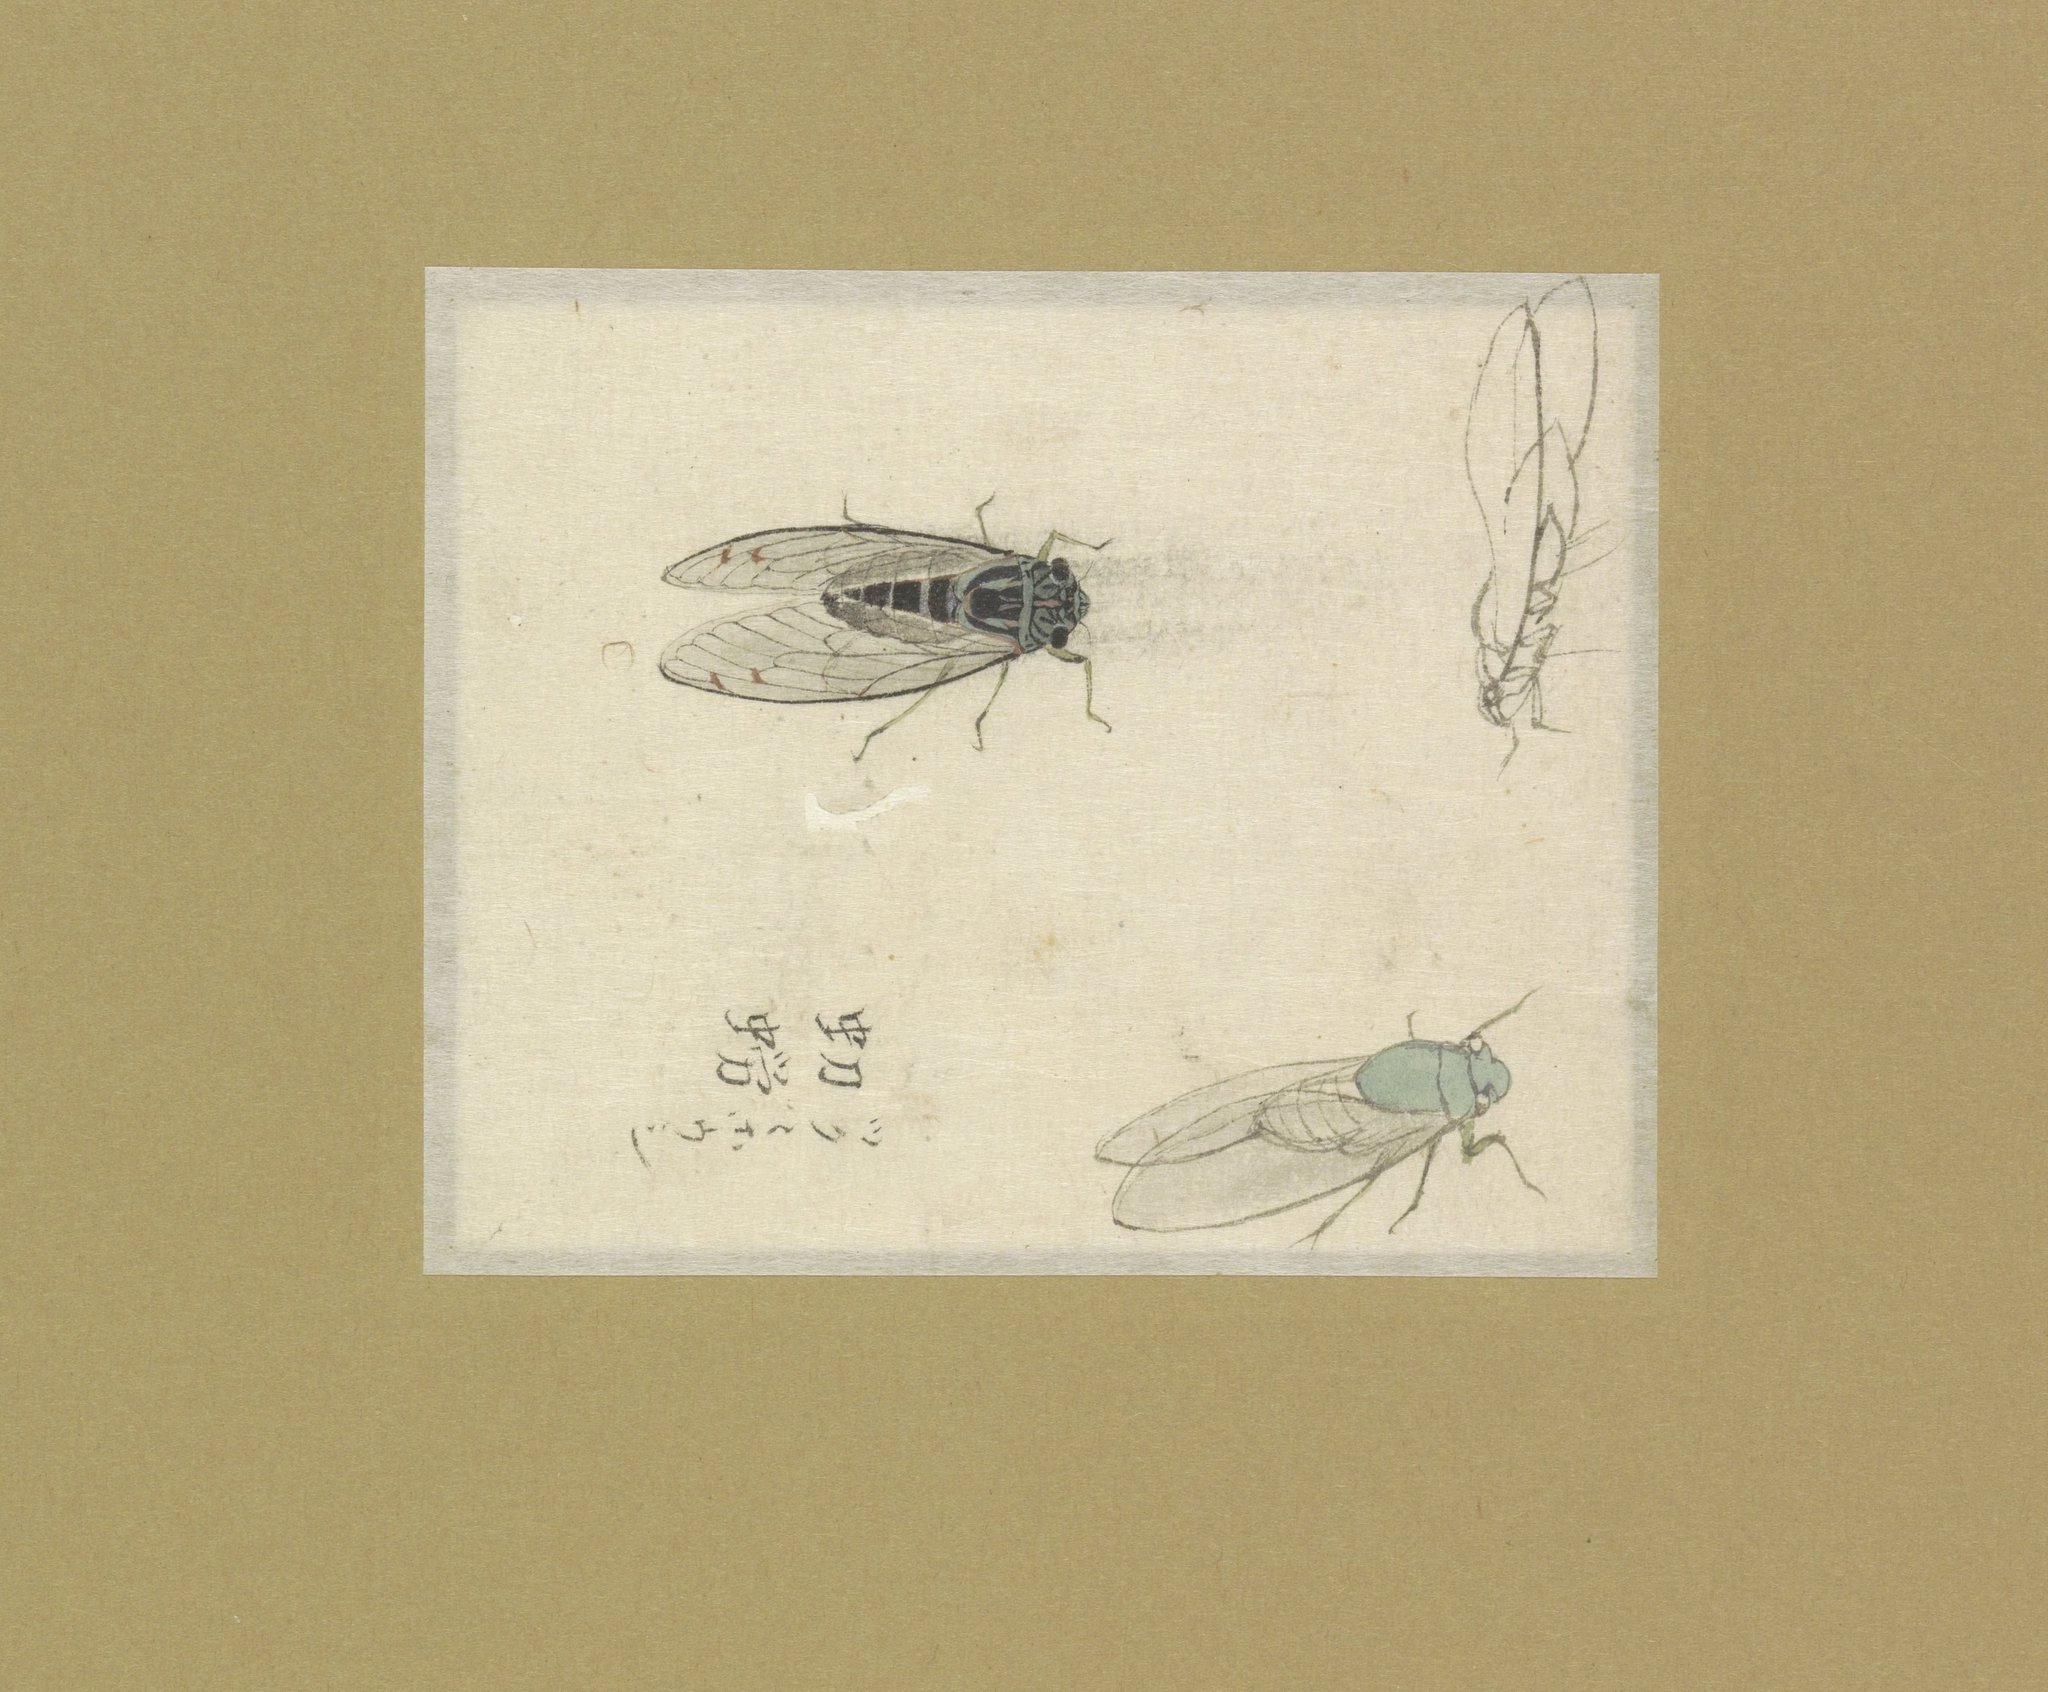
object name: watercolor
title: Drie studies van vliegen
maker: nonoyama kozan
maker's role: draughtsman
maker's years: 1780-1847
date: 1790-1847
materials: ink, paper, watercolor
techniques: brush, pen